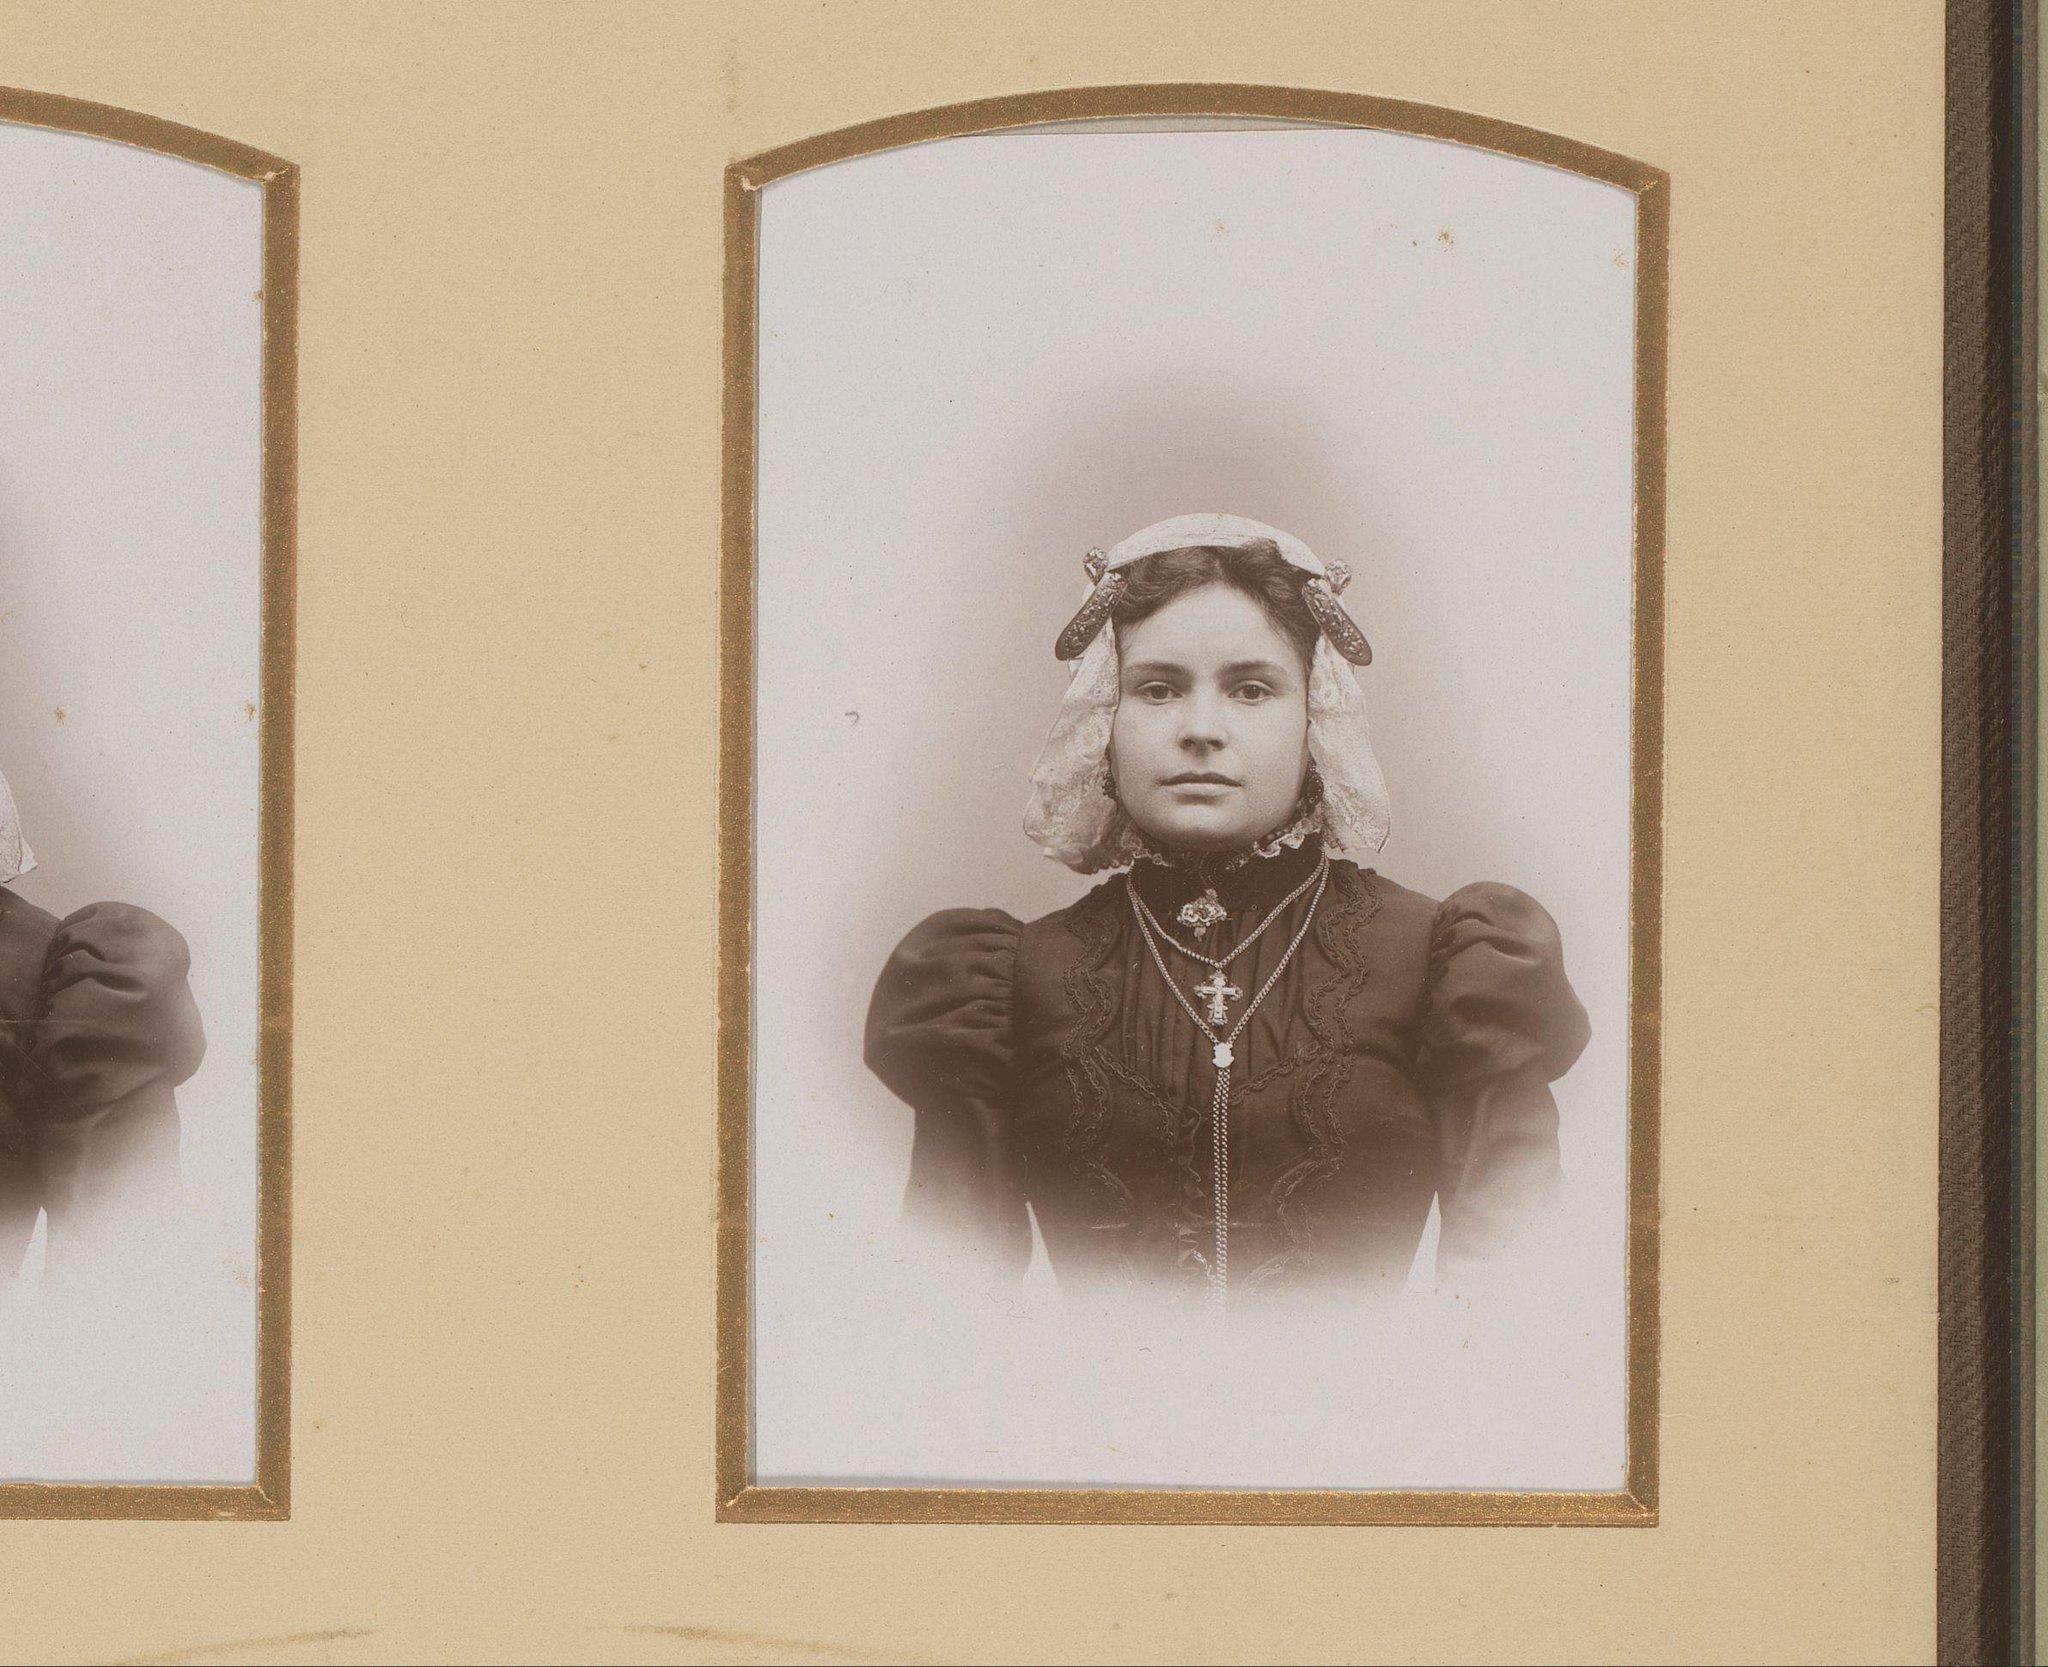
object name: carte de visite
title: Portret van een jonge vrouw met witte klederdrachtmuts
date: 1890-1918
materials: cardboard, photographic support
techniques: collodion silver print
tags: adolescent, young woman, maiden, historical persons - bb - woman, head-gear: cap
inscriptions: inscription: ‘Photographische/ Ateliers/ J. Siewers & Zoon/ Edam/ Hilversum./ Specialiteit in vergrootingen.’